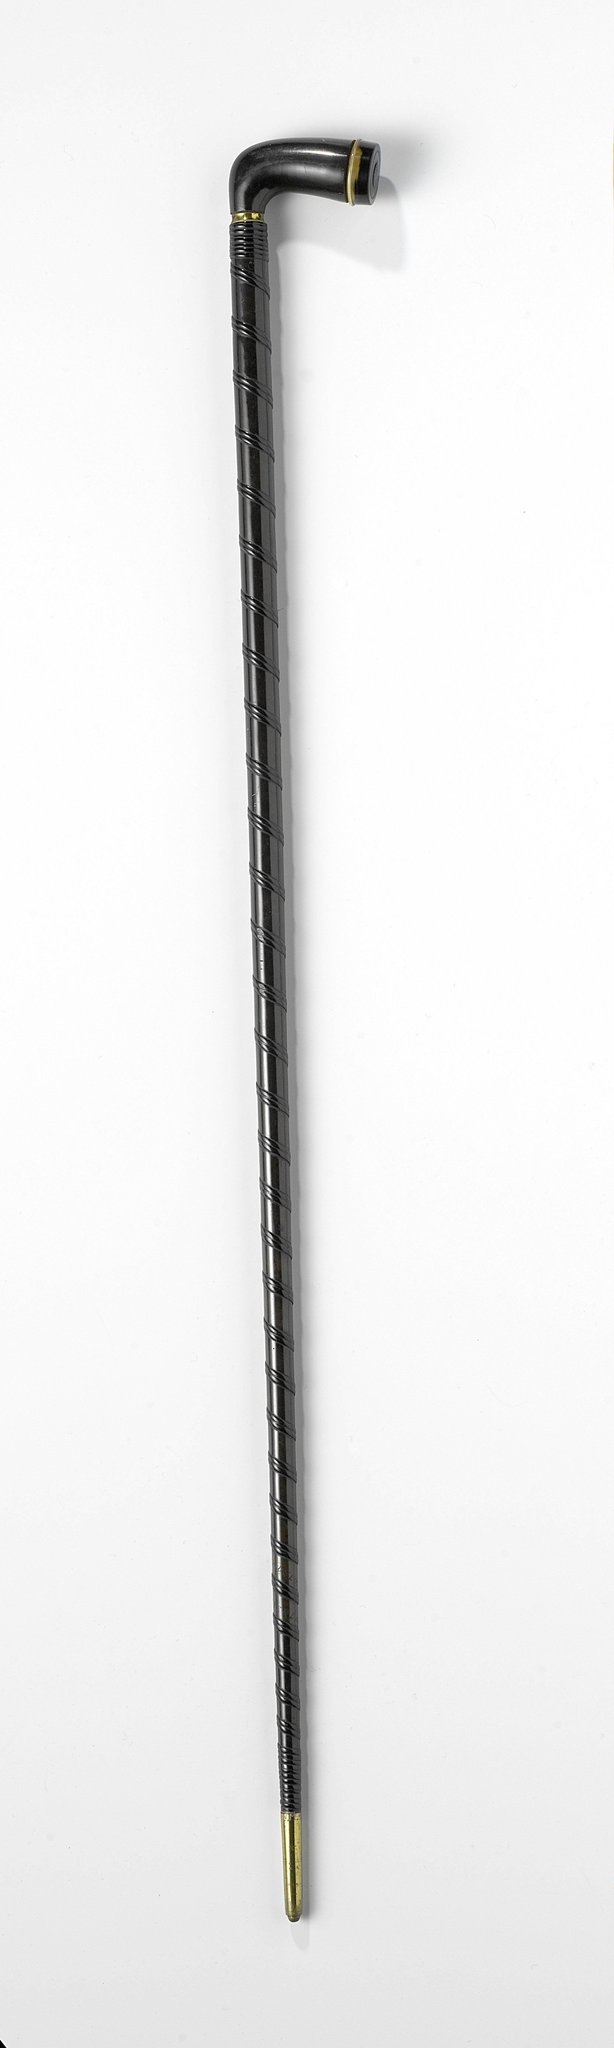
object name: walking stick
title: Wandelstok bekleed met balein en knop in de vorm van pijp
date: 1815-1840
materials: baleen, bone, brass, horn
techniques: cutting, striking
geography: london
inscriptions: name: ‘Steinberg patent London’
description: Wandelstok bekleed met zwart balein. De knop in de vorm van een pijp is van hoorn.